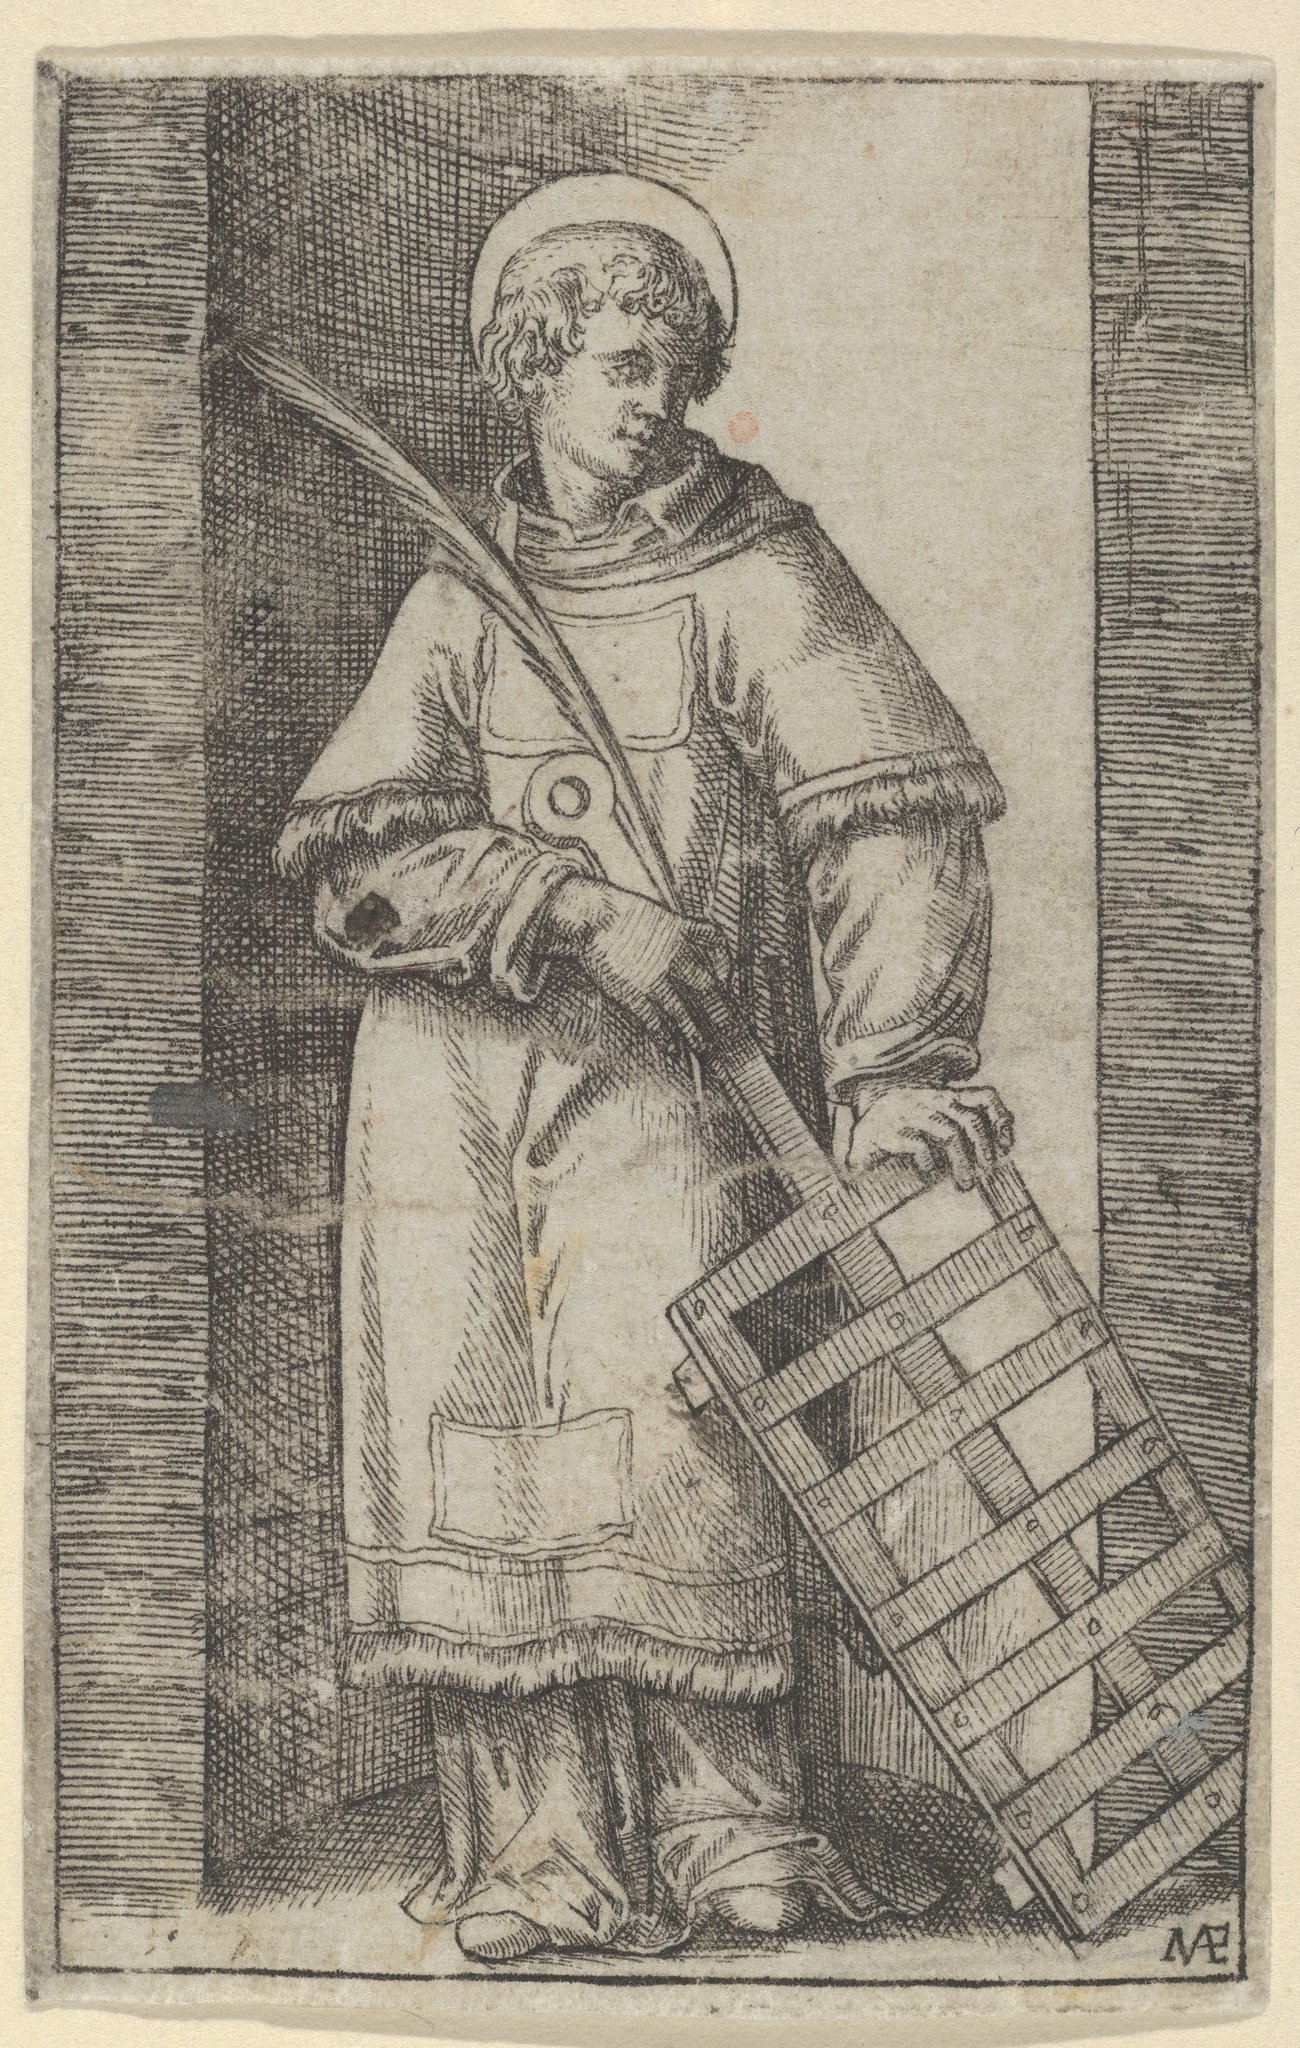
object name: print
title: Saint Vincent, left hand resting on a grill, from "Piccoli Santi" (Small Saints)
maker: marcantonio raimondi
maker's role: artist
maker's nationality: italian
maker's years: 1475-1534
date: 1500-1527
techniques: engraving, etching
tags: portraits,saints